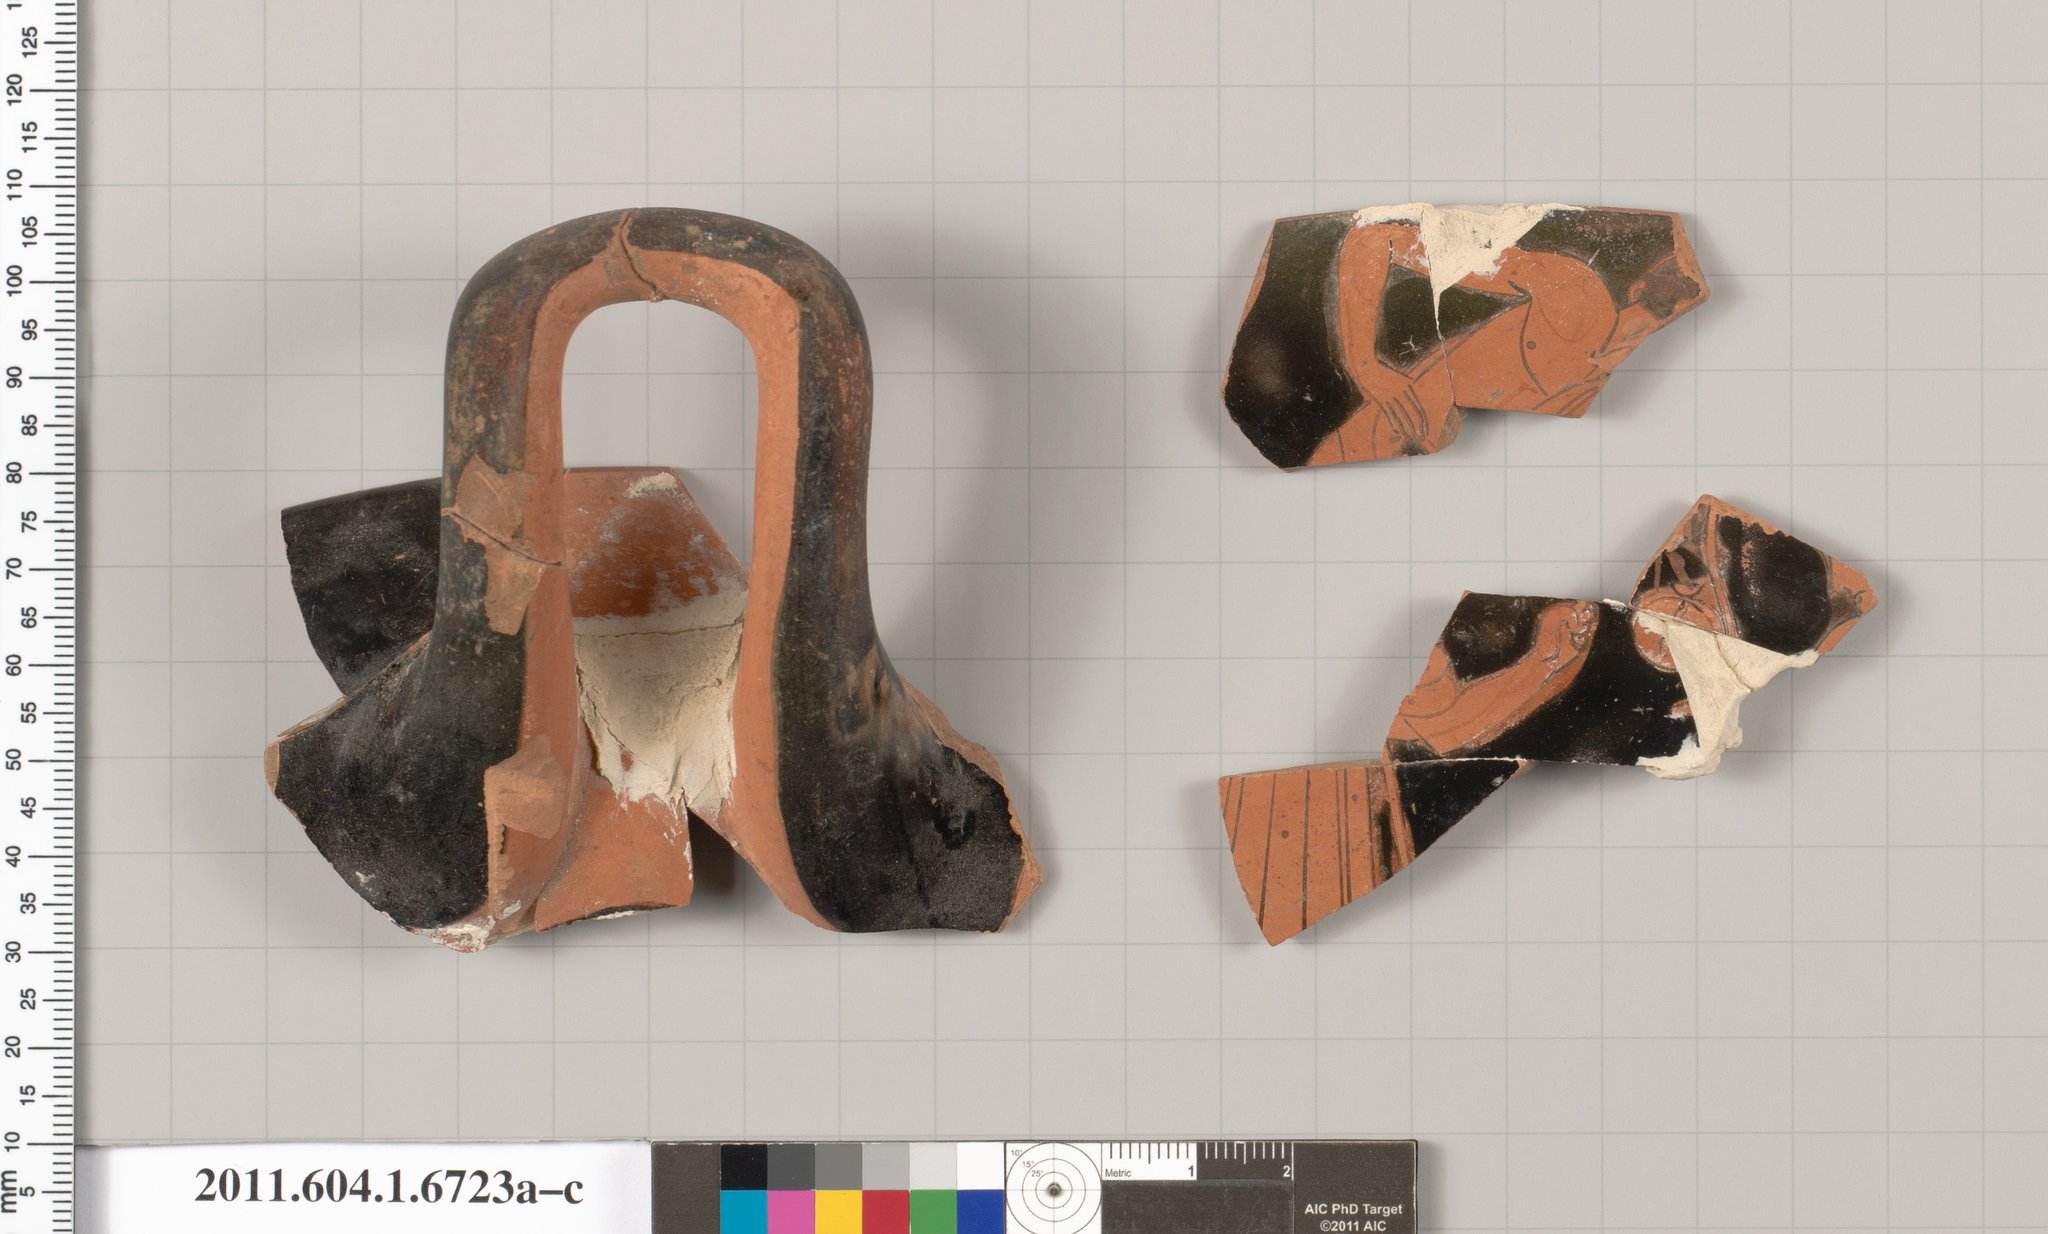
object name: kylix fragment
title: Terracotta fragments of a kylix (drinking cup)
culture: greek, attic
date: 490-470 BCE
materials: terracotta